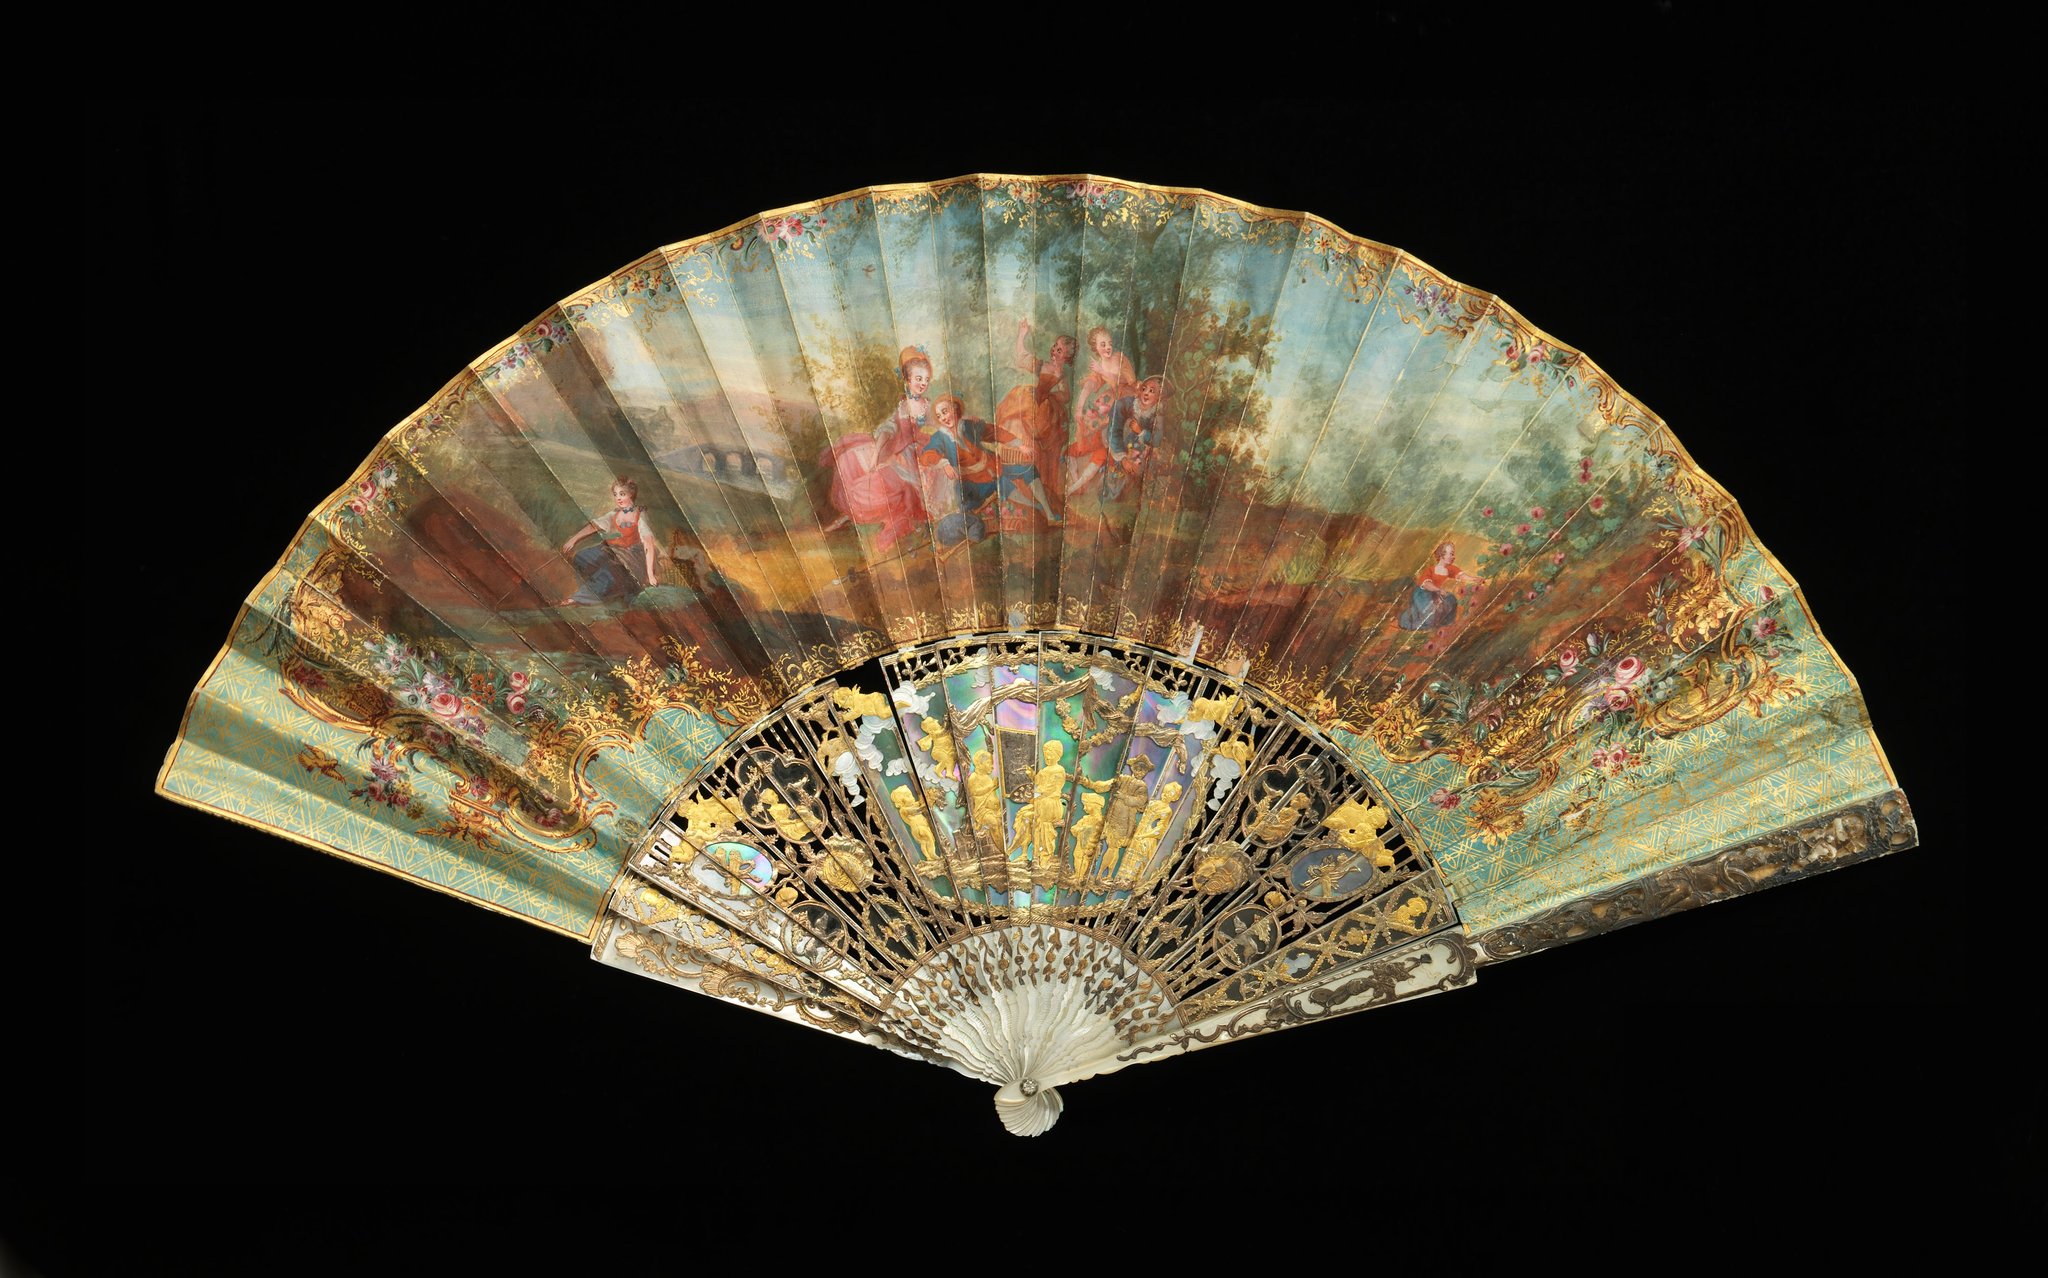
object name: fan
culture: french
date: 1870-1890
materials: gouache, metal, mother of pearl, paper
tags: children,men,women